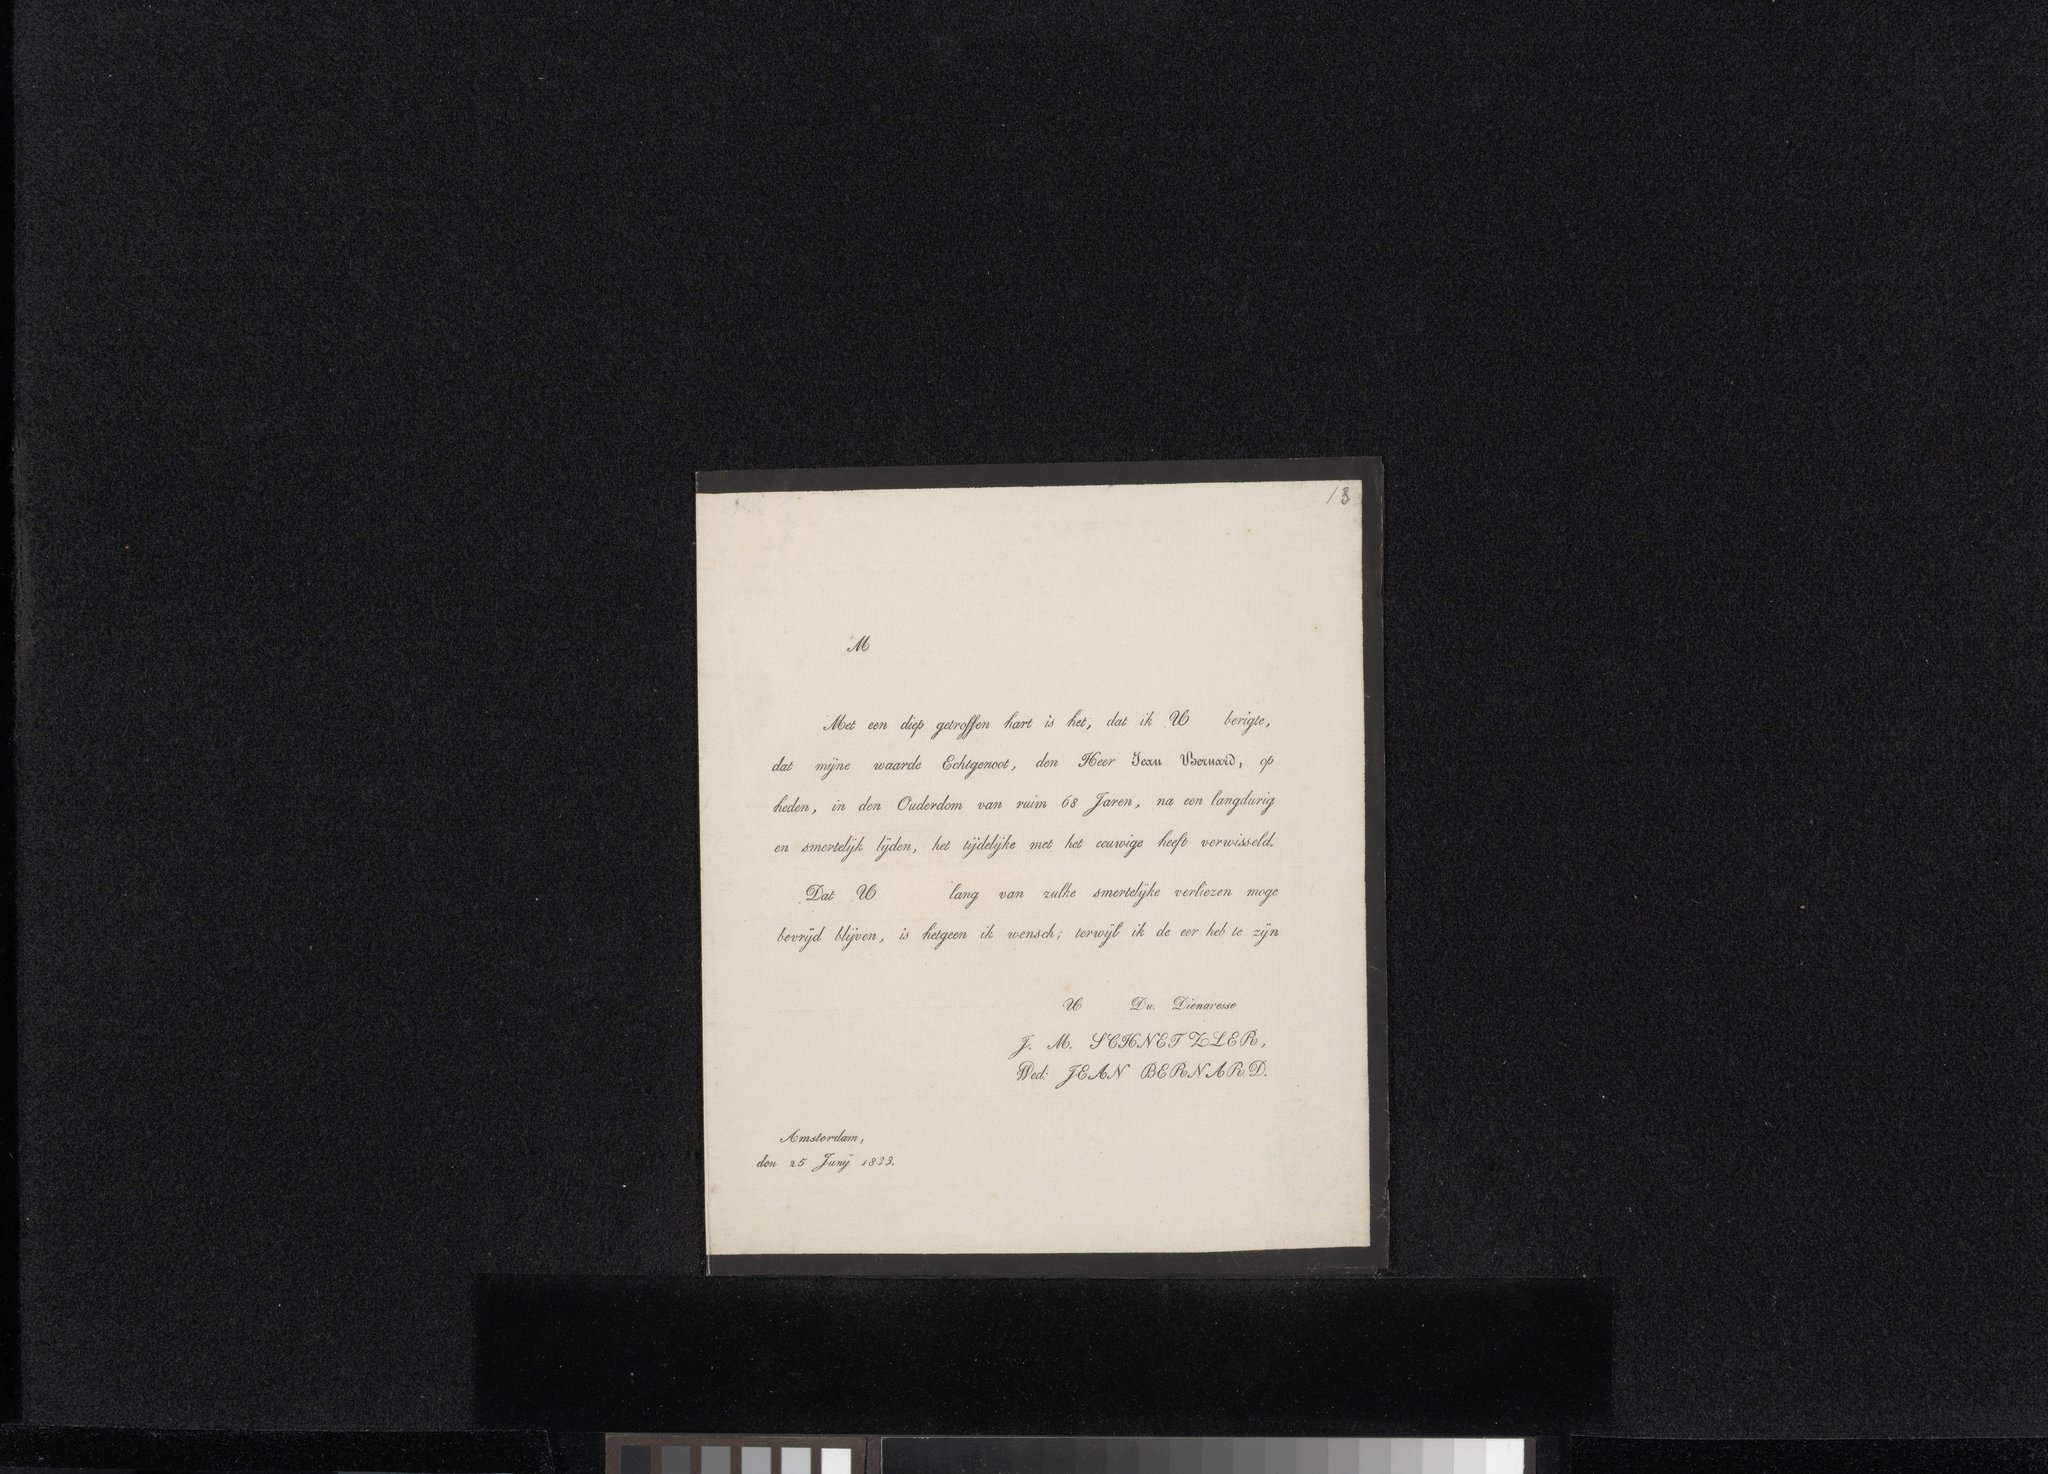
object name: overlijdensbericht, overlijdensadvertentie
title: Overlijdensbericht betreffende Jean Bernard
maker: johanna magdalena schnetzler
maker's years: 1764-1843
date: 1833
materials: paper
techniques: printing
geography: amsterdam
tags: draughtsman, jean bernard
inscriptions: collector's mark: Lugt 2233, watermark